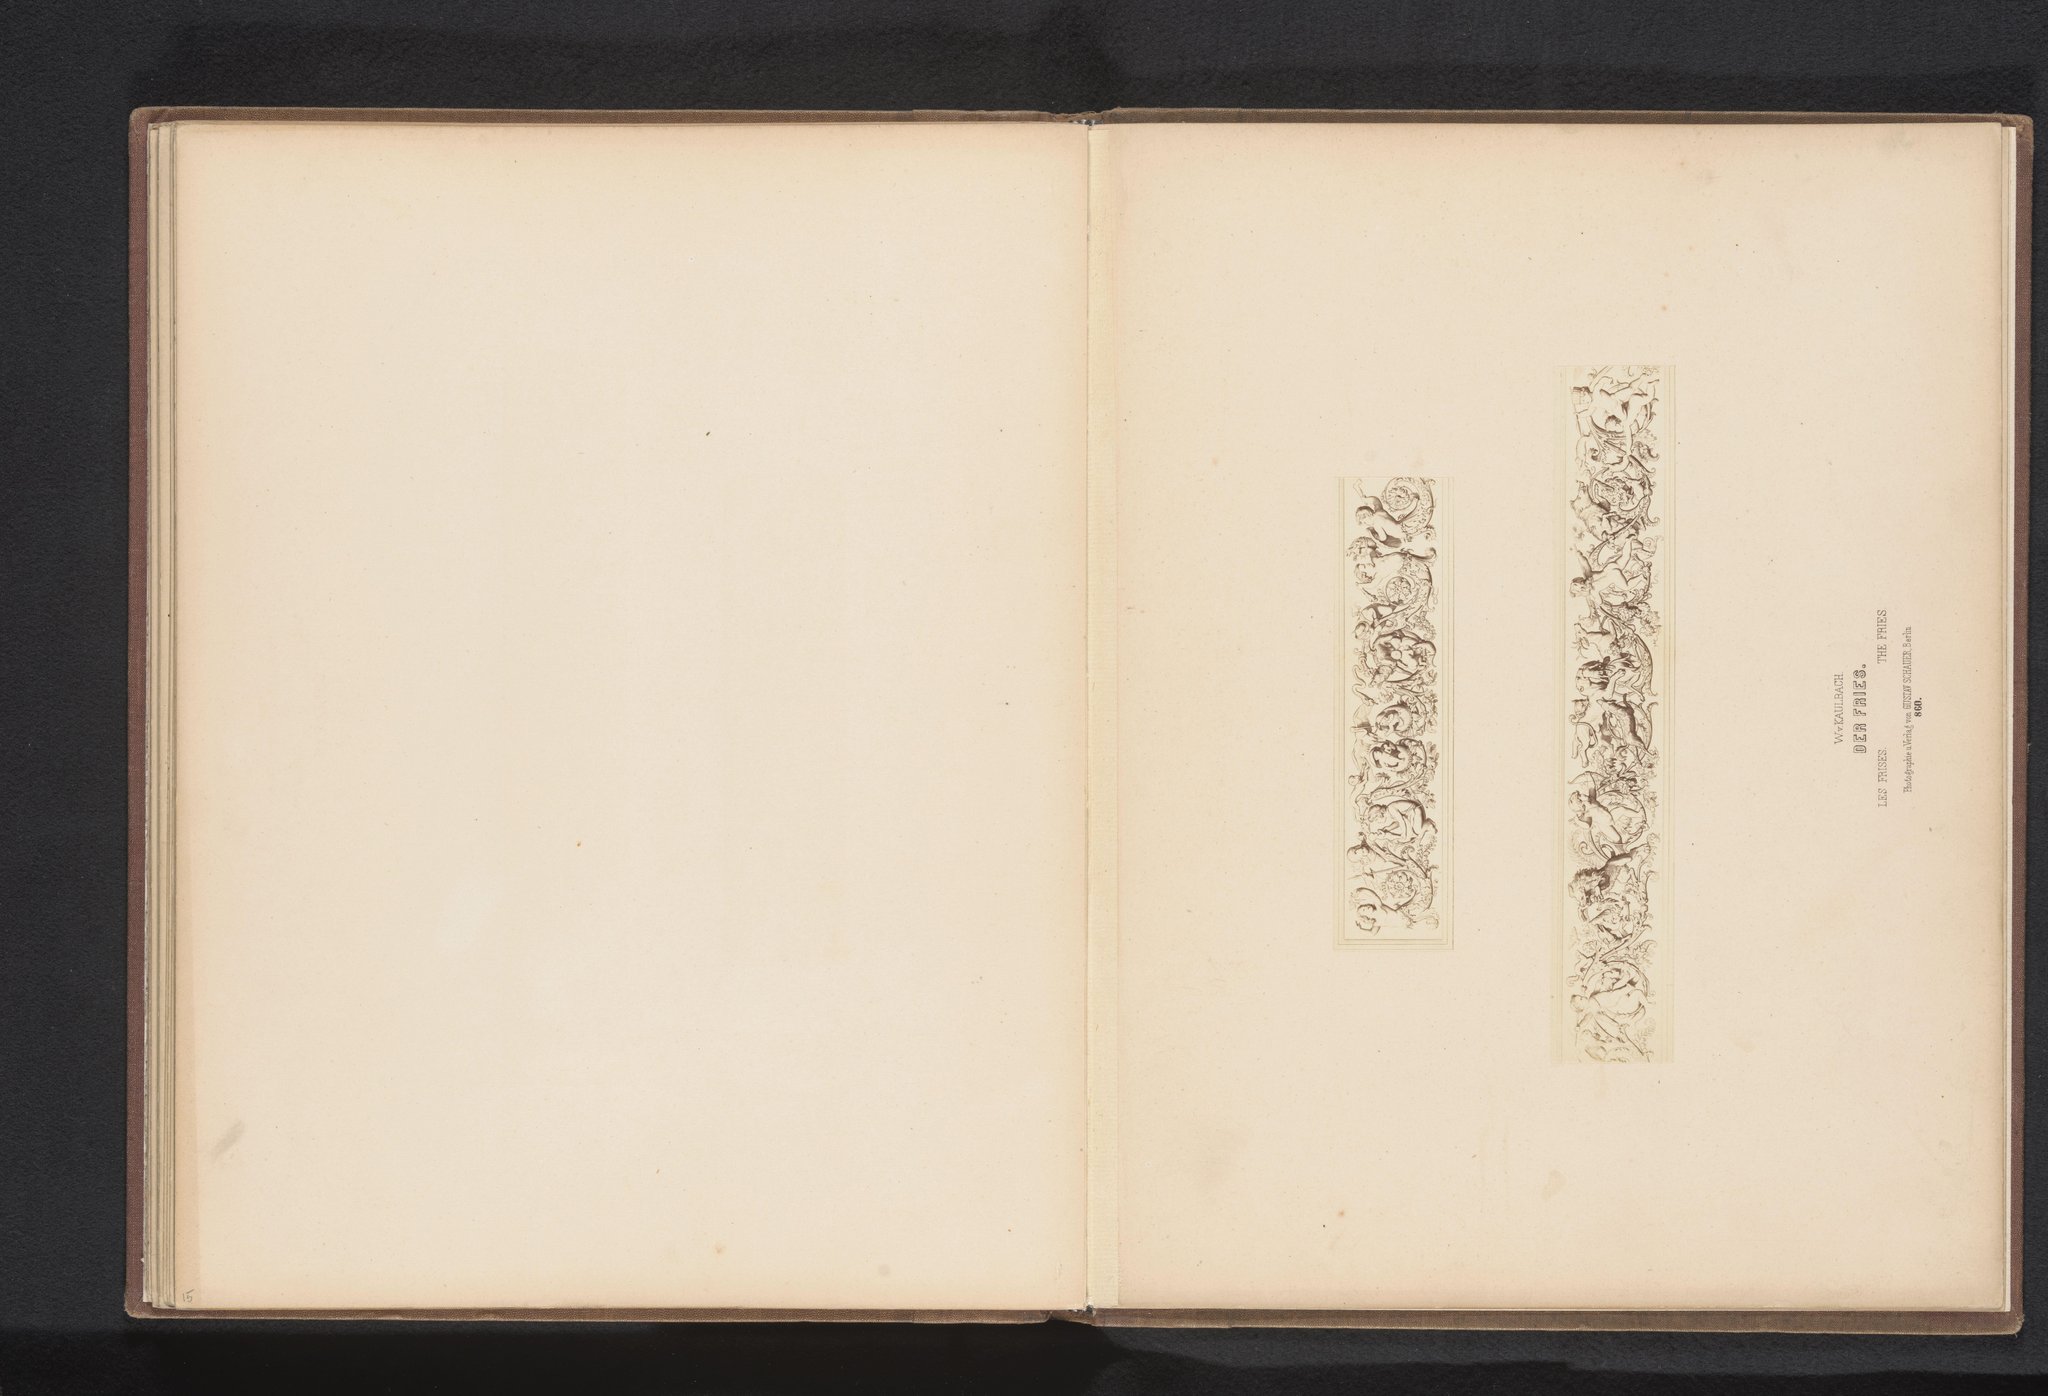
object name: page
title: Der fries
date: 1860-1870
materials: photographic support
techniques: albumen print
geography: berlin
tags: wall-covering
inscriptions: number: ‘860.’